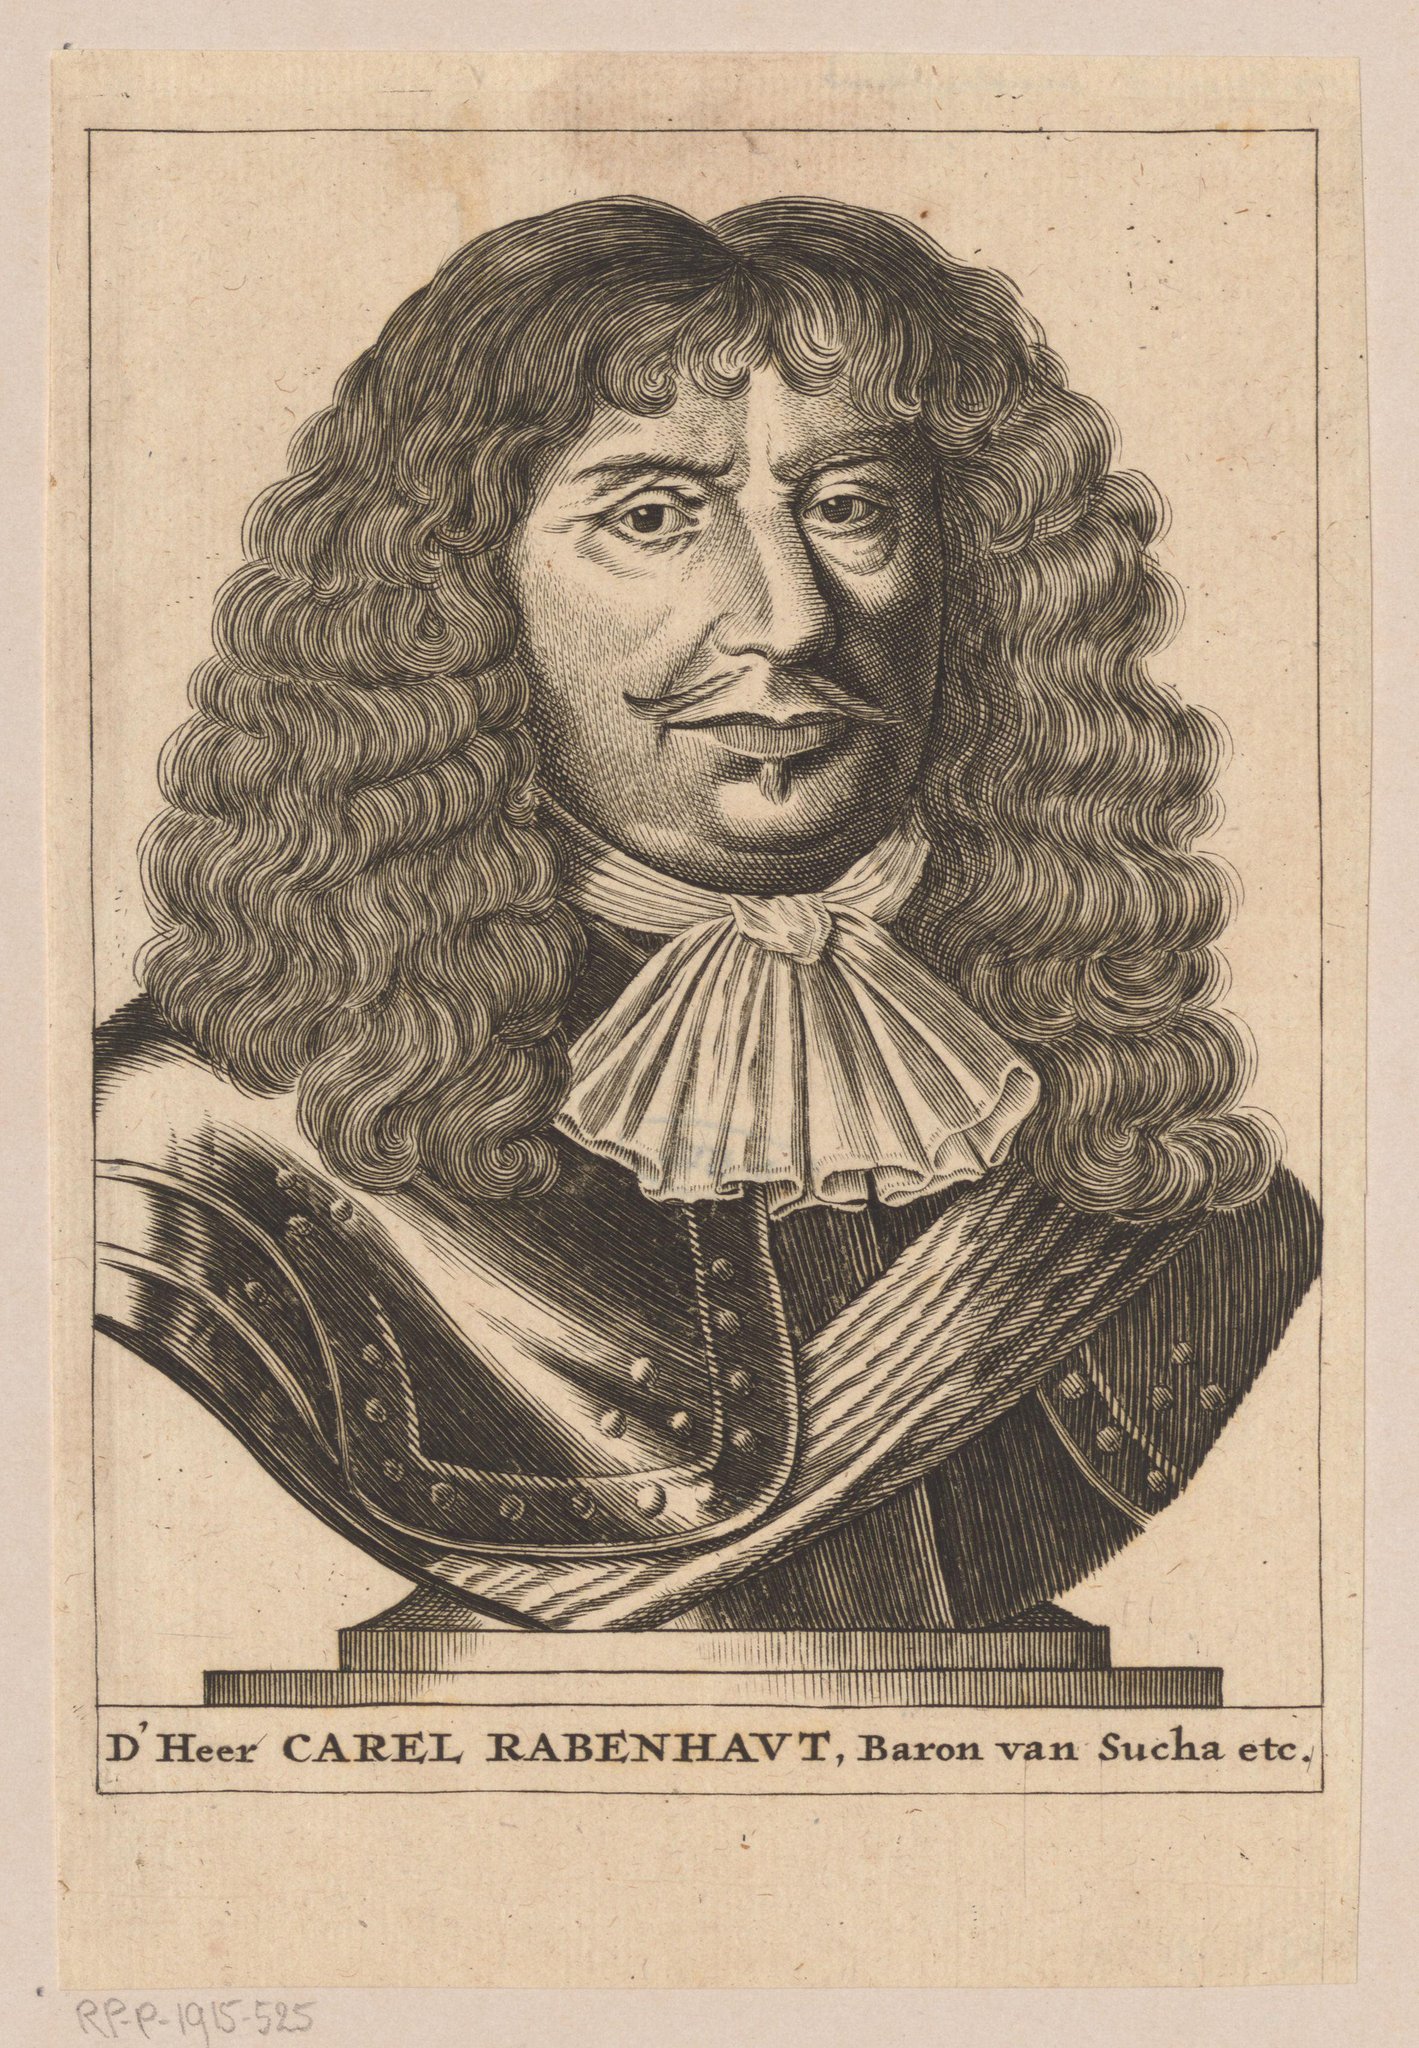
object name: print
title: Portret van Karel Rabenhaupt, baron von Sucha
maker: Anonymous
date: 1633-1749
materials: paper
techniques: engraving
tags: historical persons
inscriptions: collector's mark: Lugt 2228